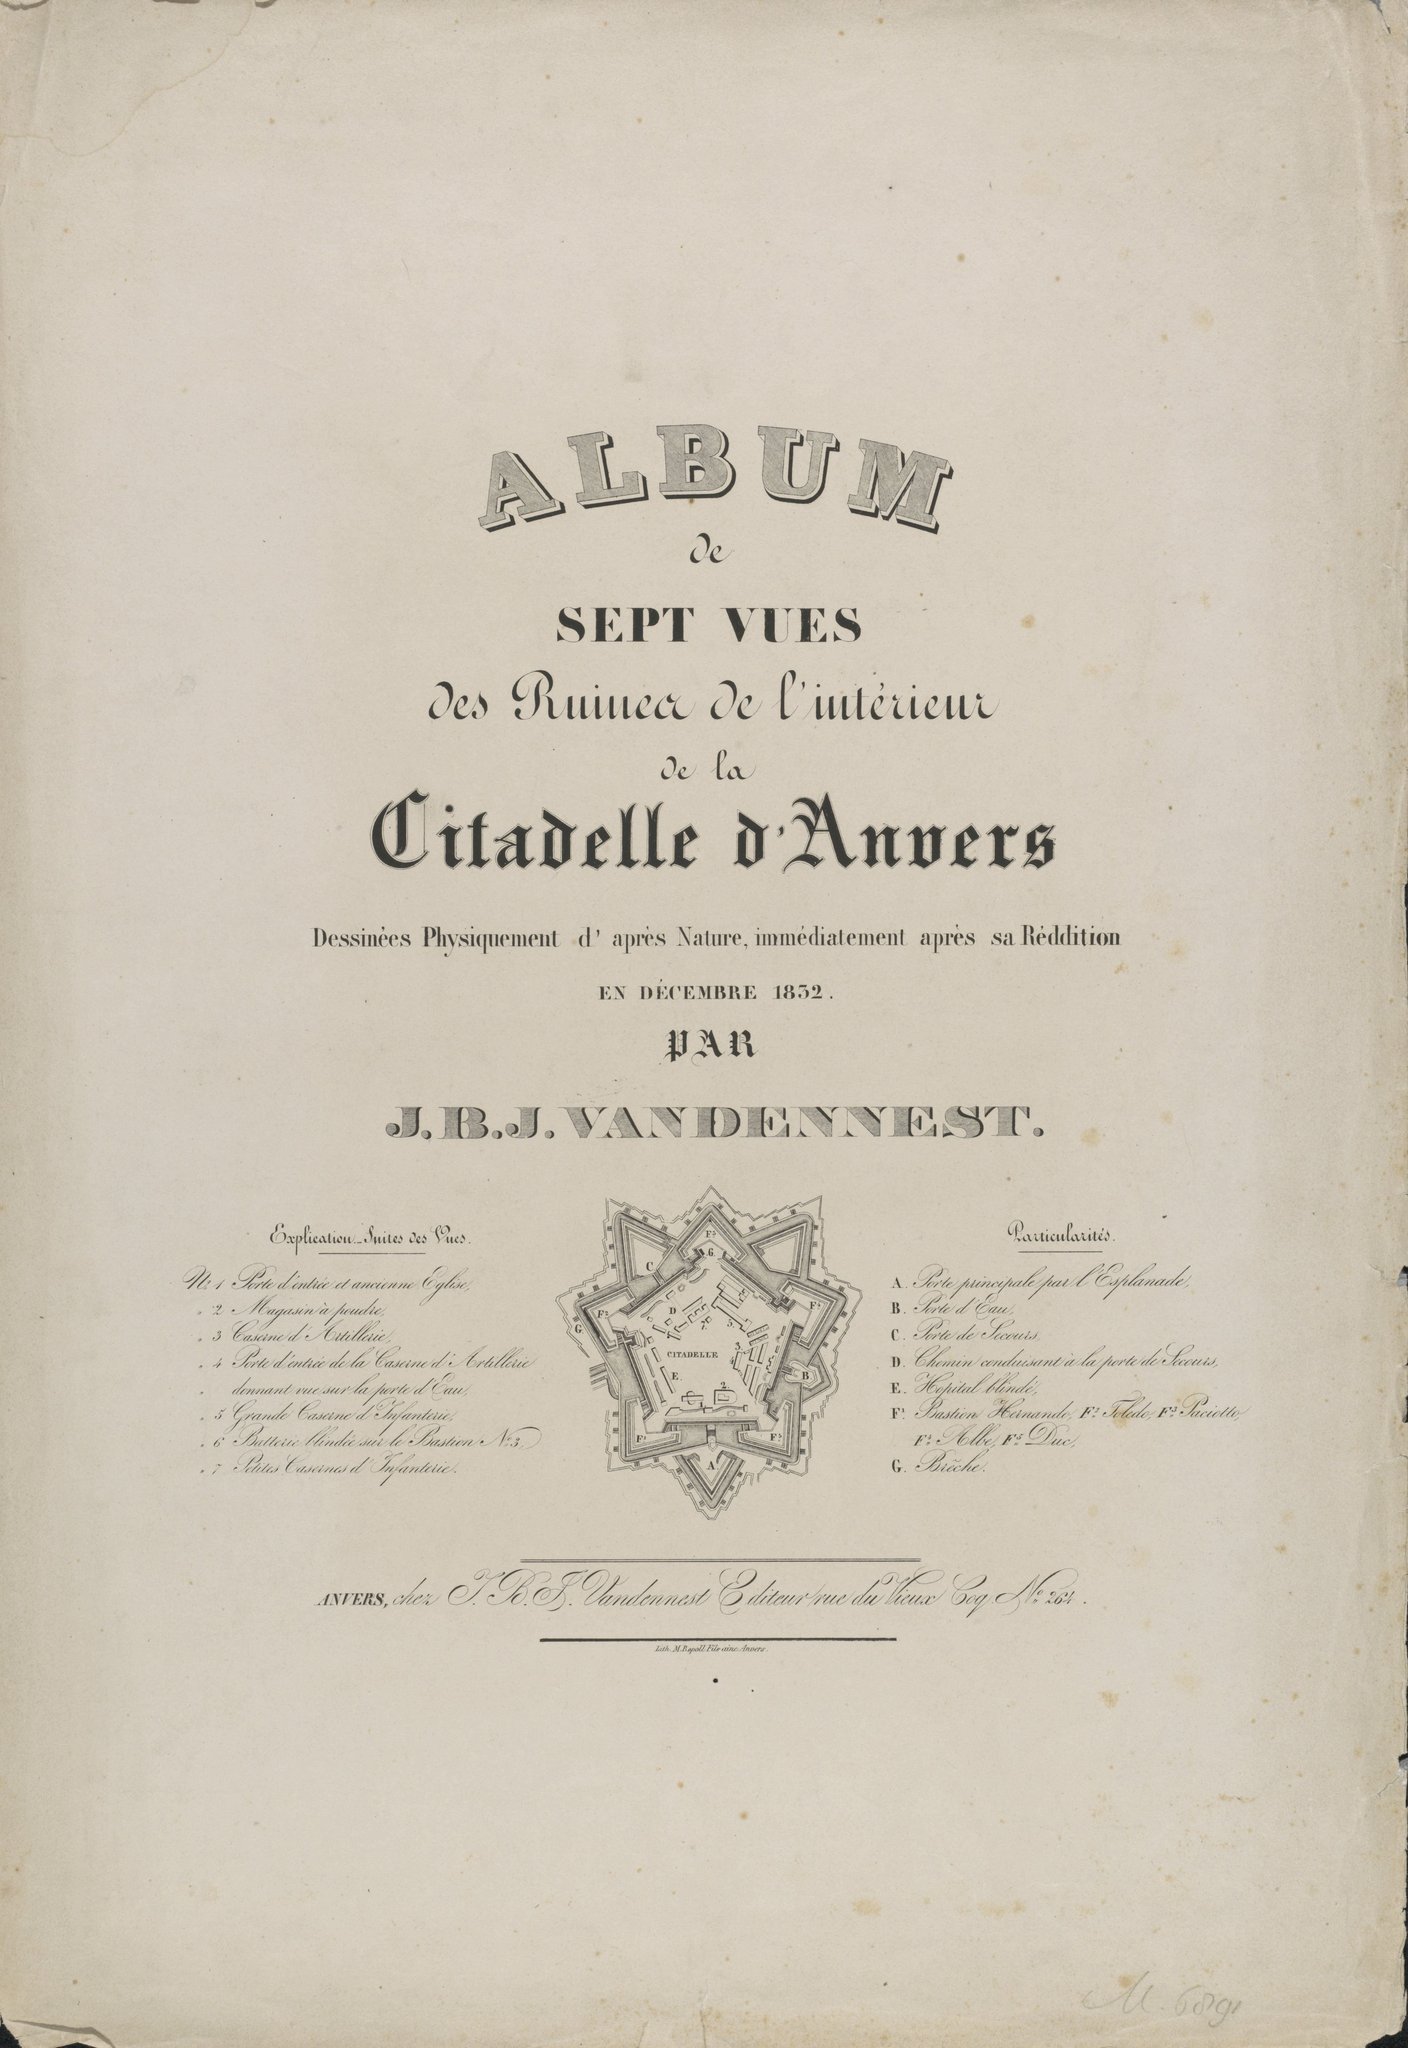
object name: titelprent, frontispice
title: Album de sept vues des Ruines de l'intérieur de la Citadelle d'Anvers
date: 1832-1833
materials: paper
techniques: lithograph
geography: antwerp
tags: permanent fortifications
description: Titelprent bij de serie van zeven platen van de ruïnes van het interieur van de Citadel van Antwerpen, na de overgave in december 1832. Typografische titel met een lijst van de zeven platen en een plattegrond van de vesting met legenda A-G.